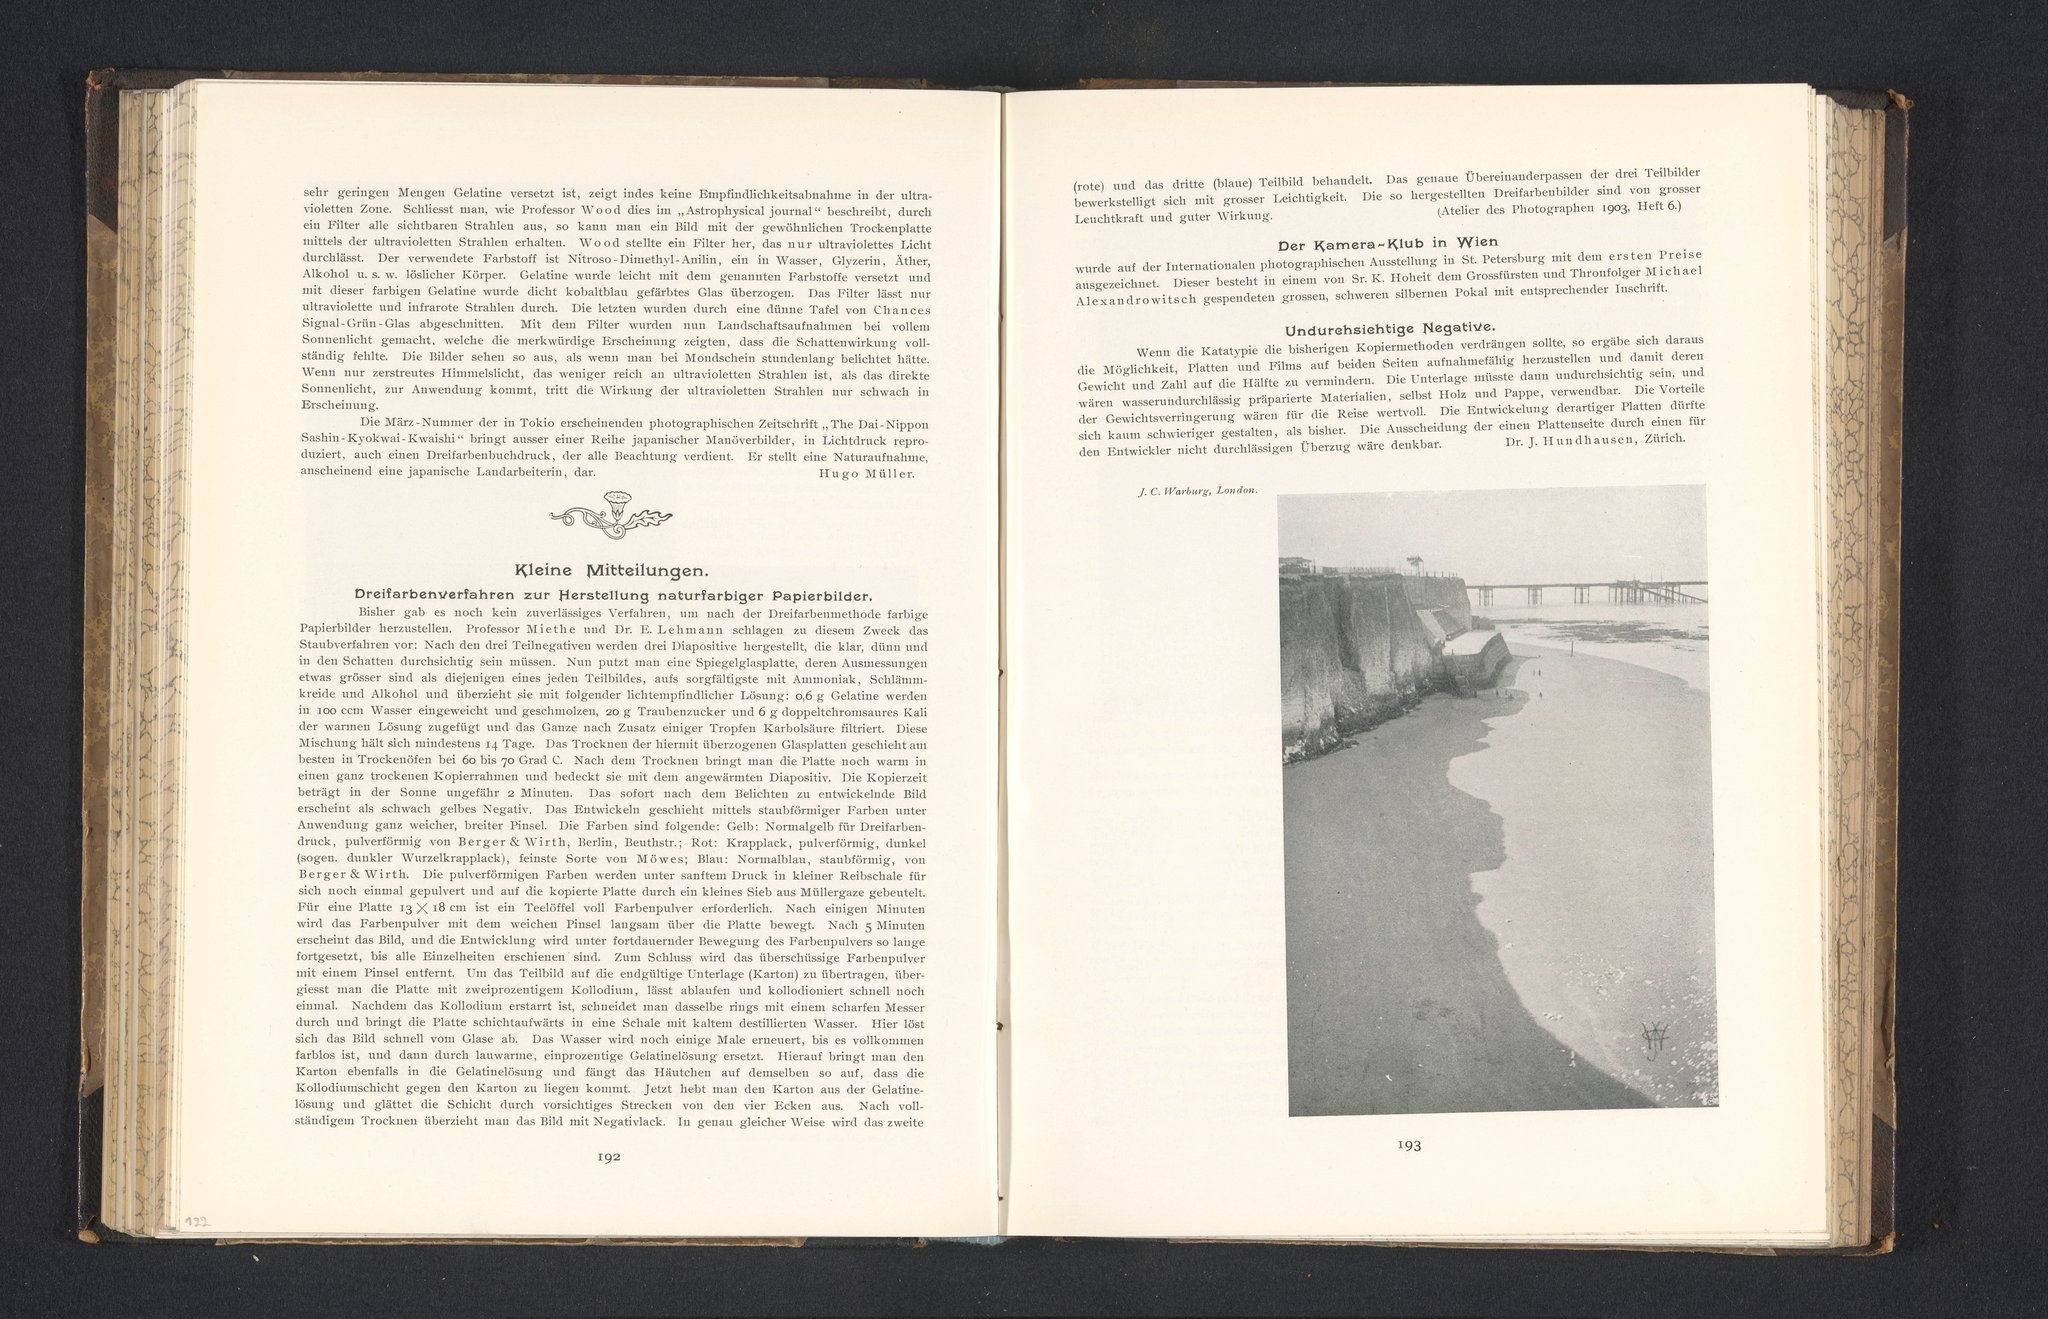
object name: page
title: Gezicht op een strand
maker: john cimon warburg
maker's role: fotograaf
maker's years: 1867-1931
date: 1898-1903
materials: paper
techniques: autotype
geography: berlin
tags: beach